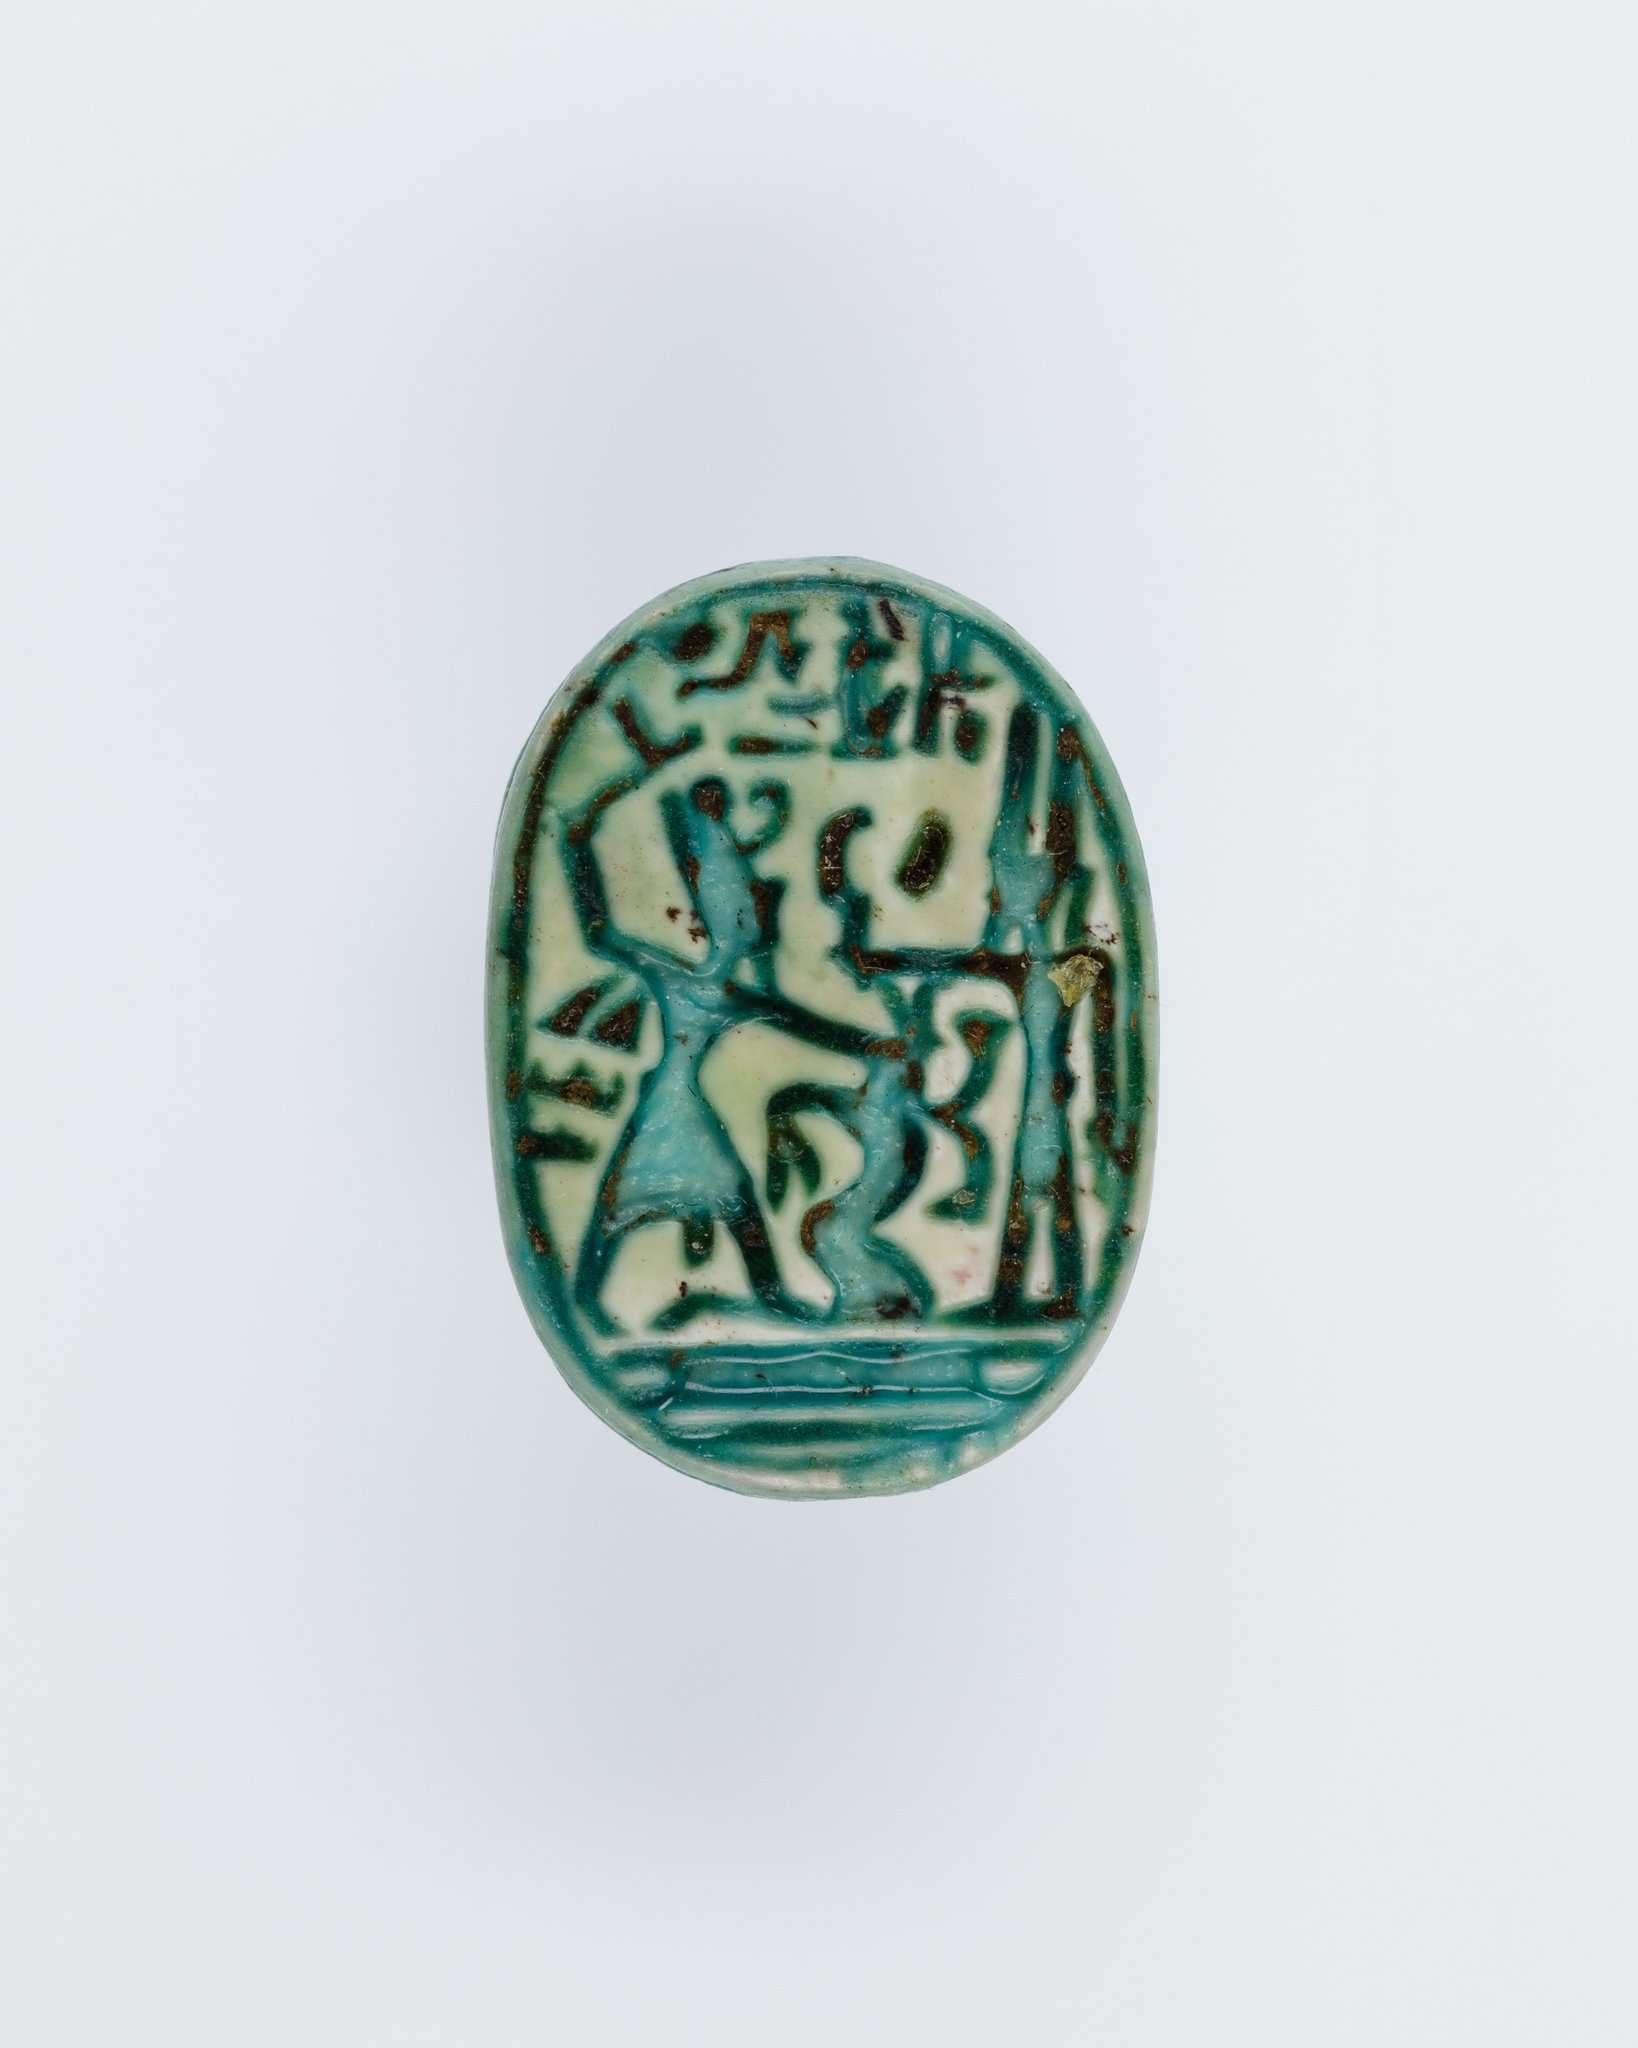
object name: scarab, ramesses ii, smiting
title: Scarab Depicting Ramesses II Smiting a Prisoner Before Amun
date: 1279-1213 BCE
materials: stone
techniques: glazing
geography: egypt